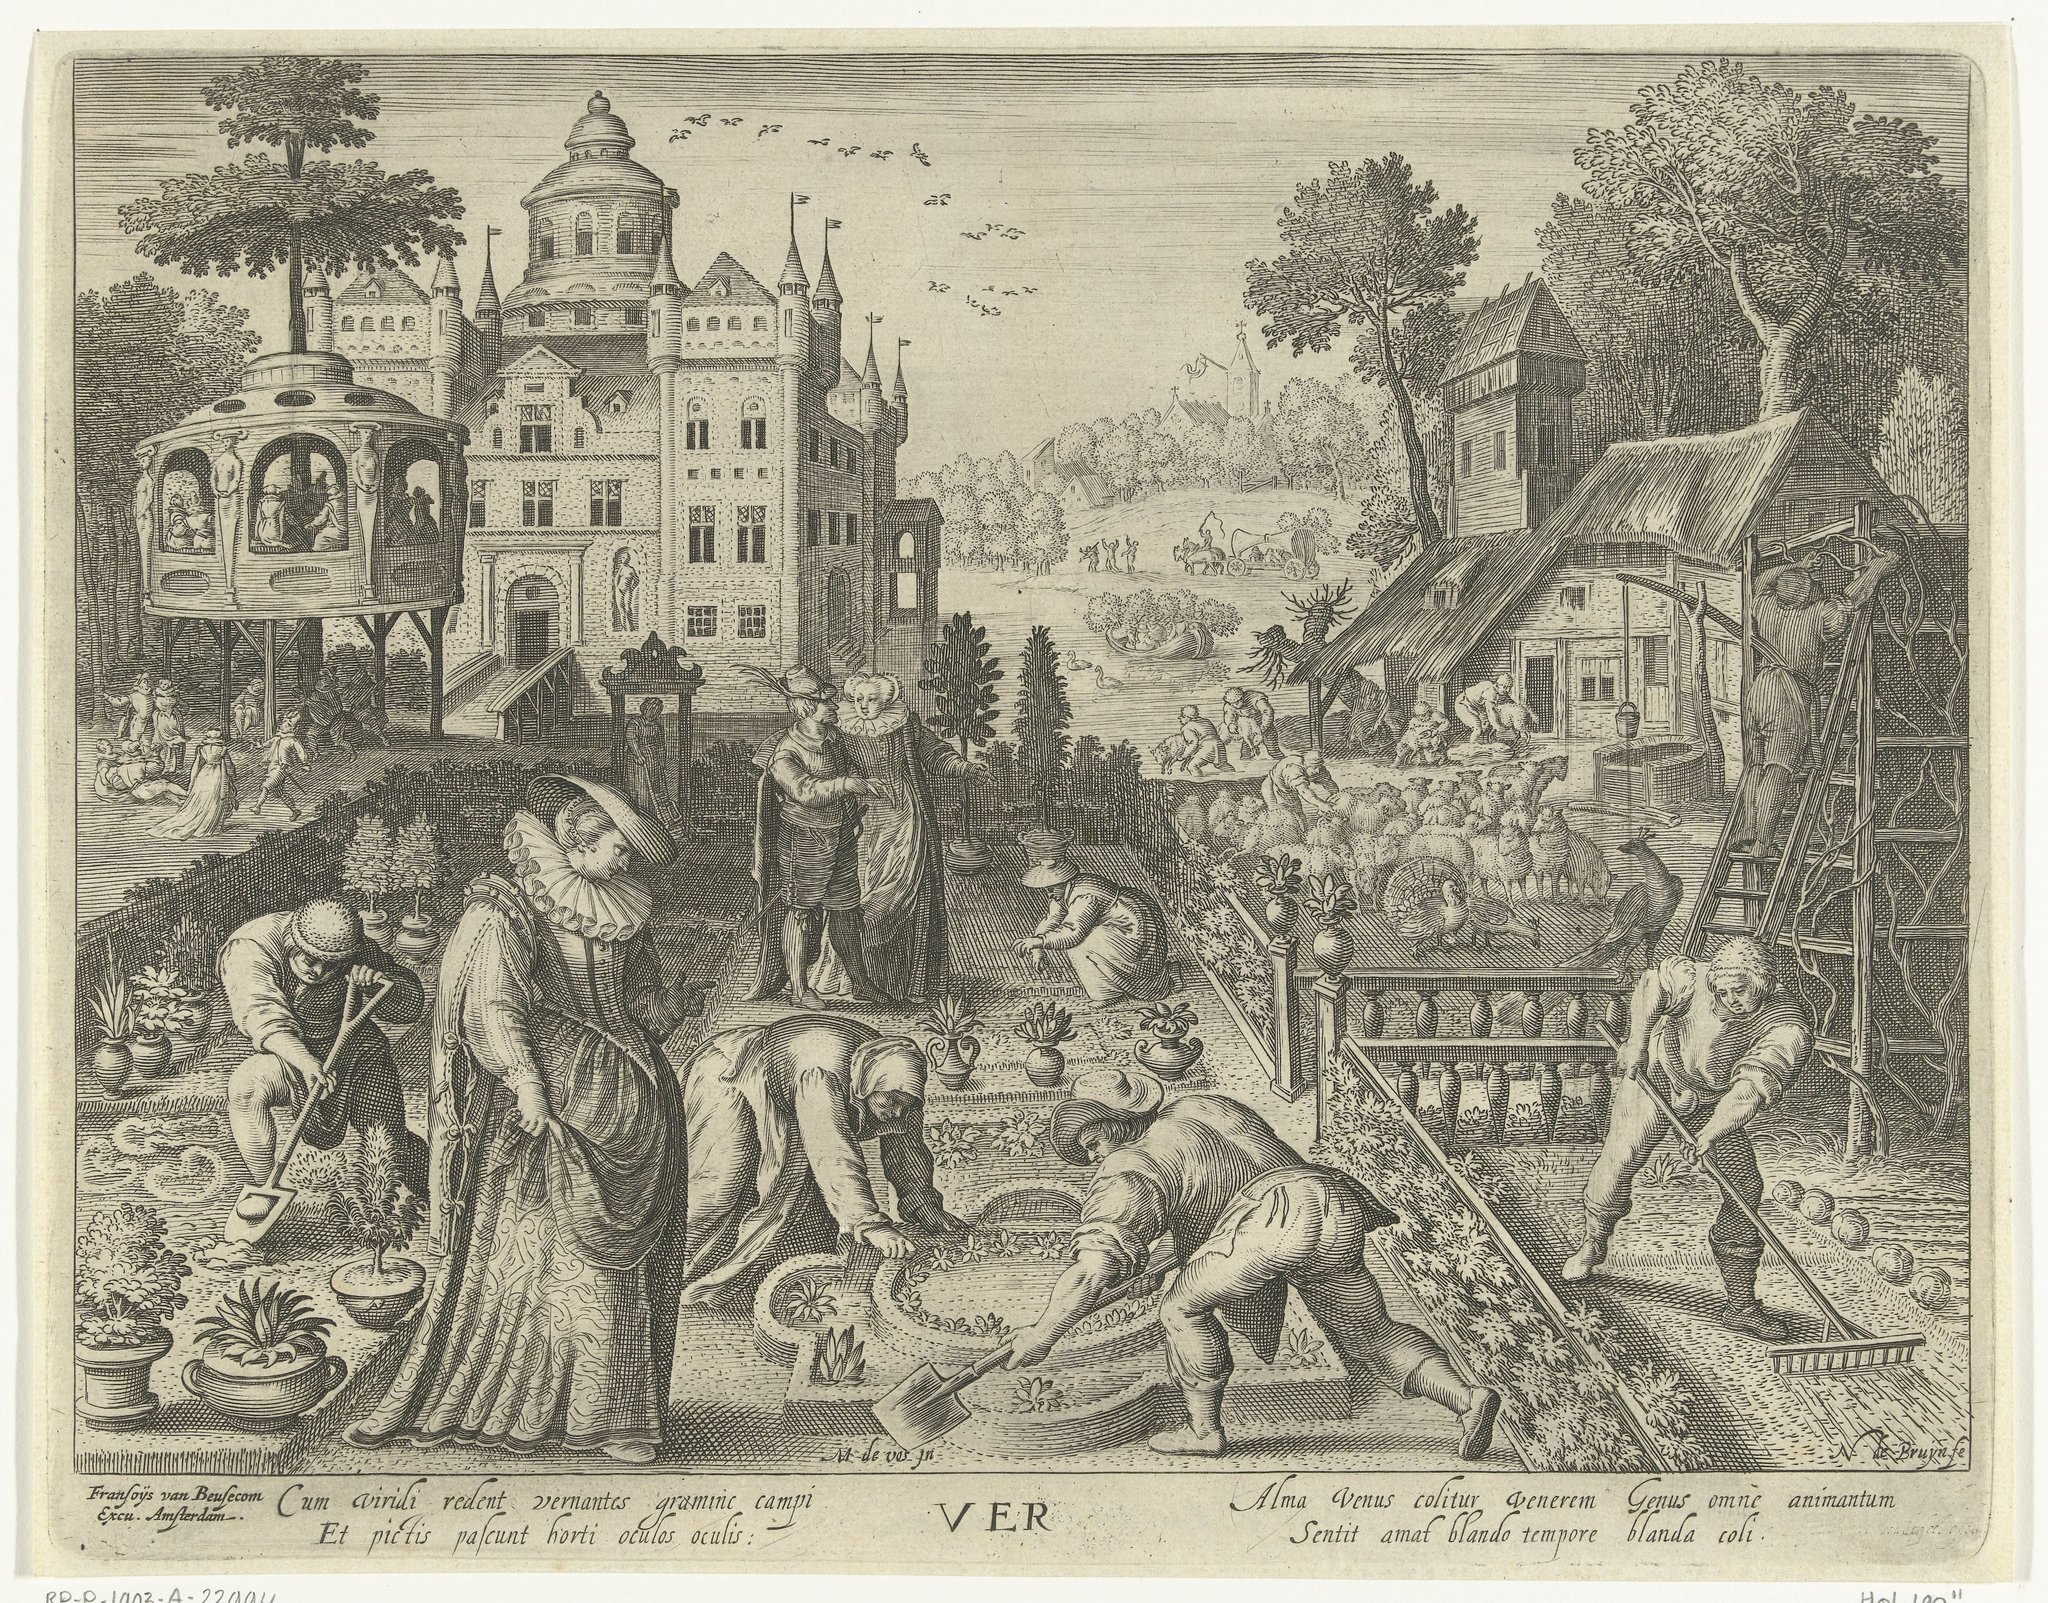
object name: print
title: Lente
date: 1581-1656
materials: paper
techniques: engraving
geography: netherlands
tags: spring ~ human activities (the four seasons of the year)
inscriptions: collector's mark: Lugt 567, collector's mark: Lugt 2228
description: Tuin van kasteel met activiteiten die plaatsvinden in de lente: in de tuin wordt gesnoeid en geharkt en schapen worden geschoren op het erf van de boerderij. In een prieel worden dames het hof gemaakt. Onder in de marge staat een vers.